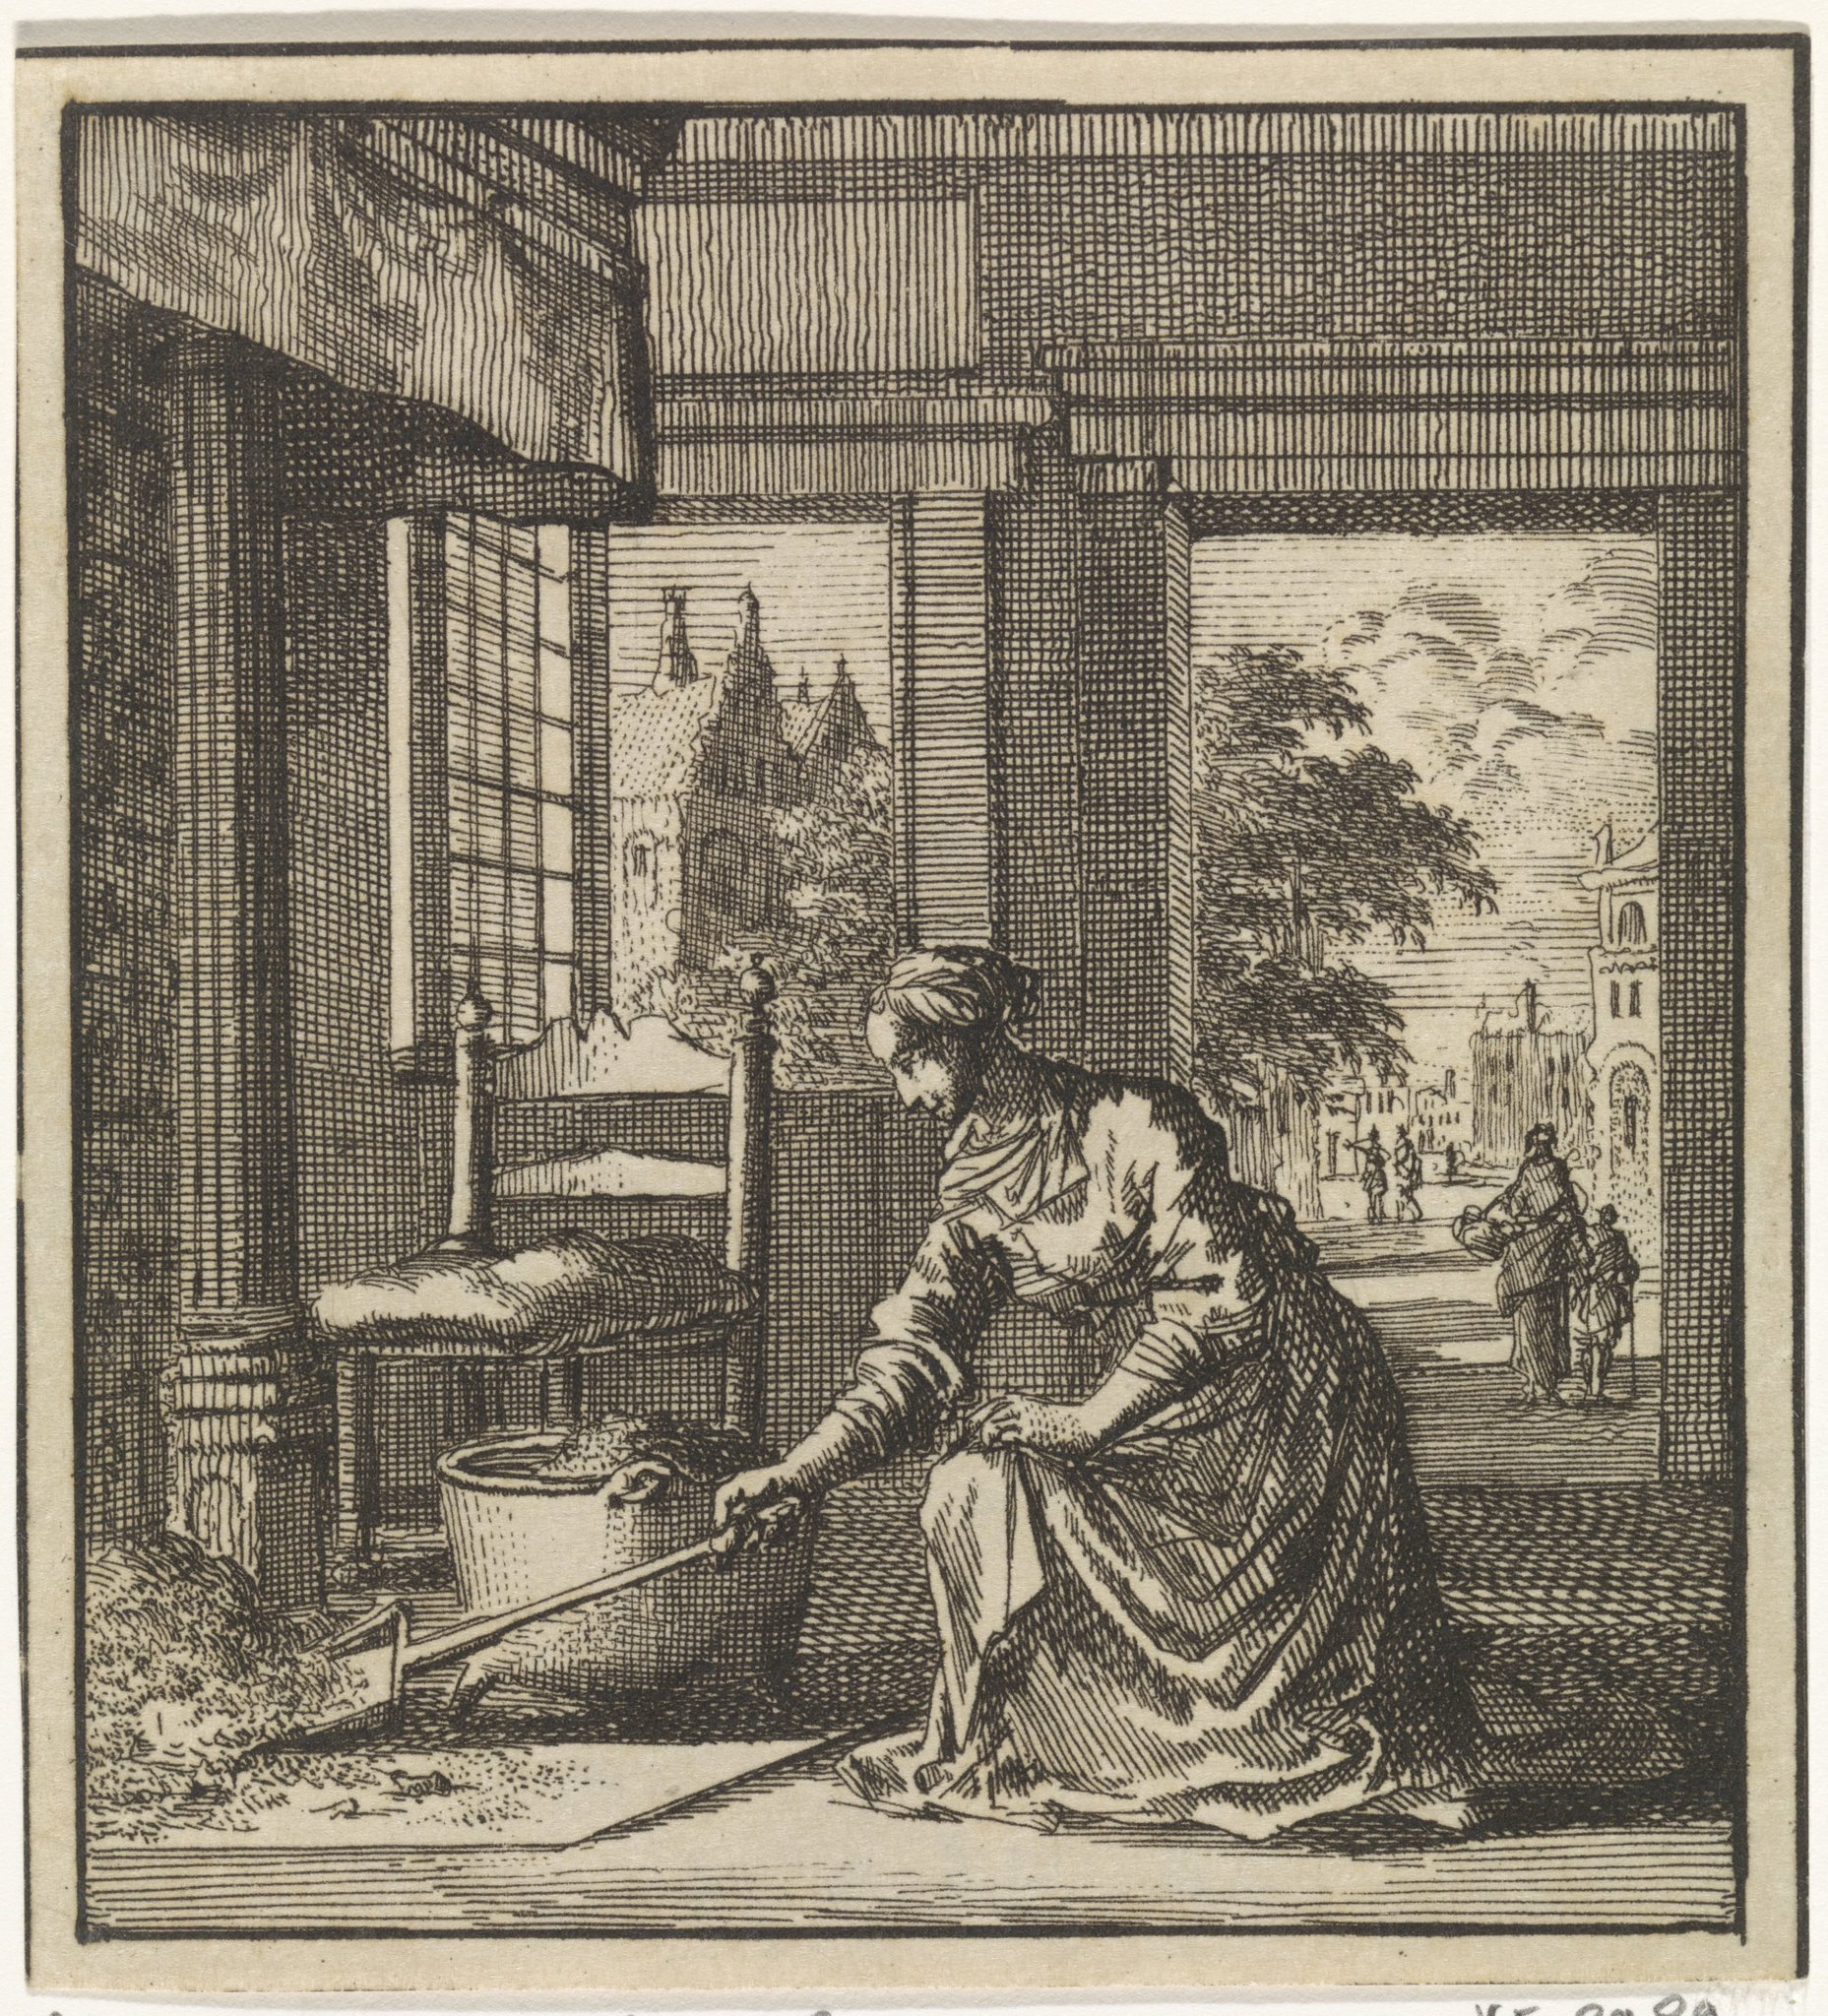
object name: print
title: Vrouw schept de as uit de haard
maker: jan luyken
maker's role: draughtsman, print maker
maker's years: 1649-1712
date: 1711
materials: paper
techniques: etching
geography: amsterdam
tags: chimney, ash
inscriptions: collector's mark: Lugt 2228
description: Proefdruk van illustratie voor: Luyken, Jan. Het leerzaam huisraad, vertoond in vyftig konstige figuuren, met godlyke spreuken en stichtelyke verzen: Pieter Arentsz. II (wed.) en Cornelis van der Sys, 1711, p. 138.